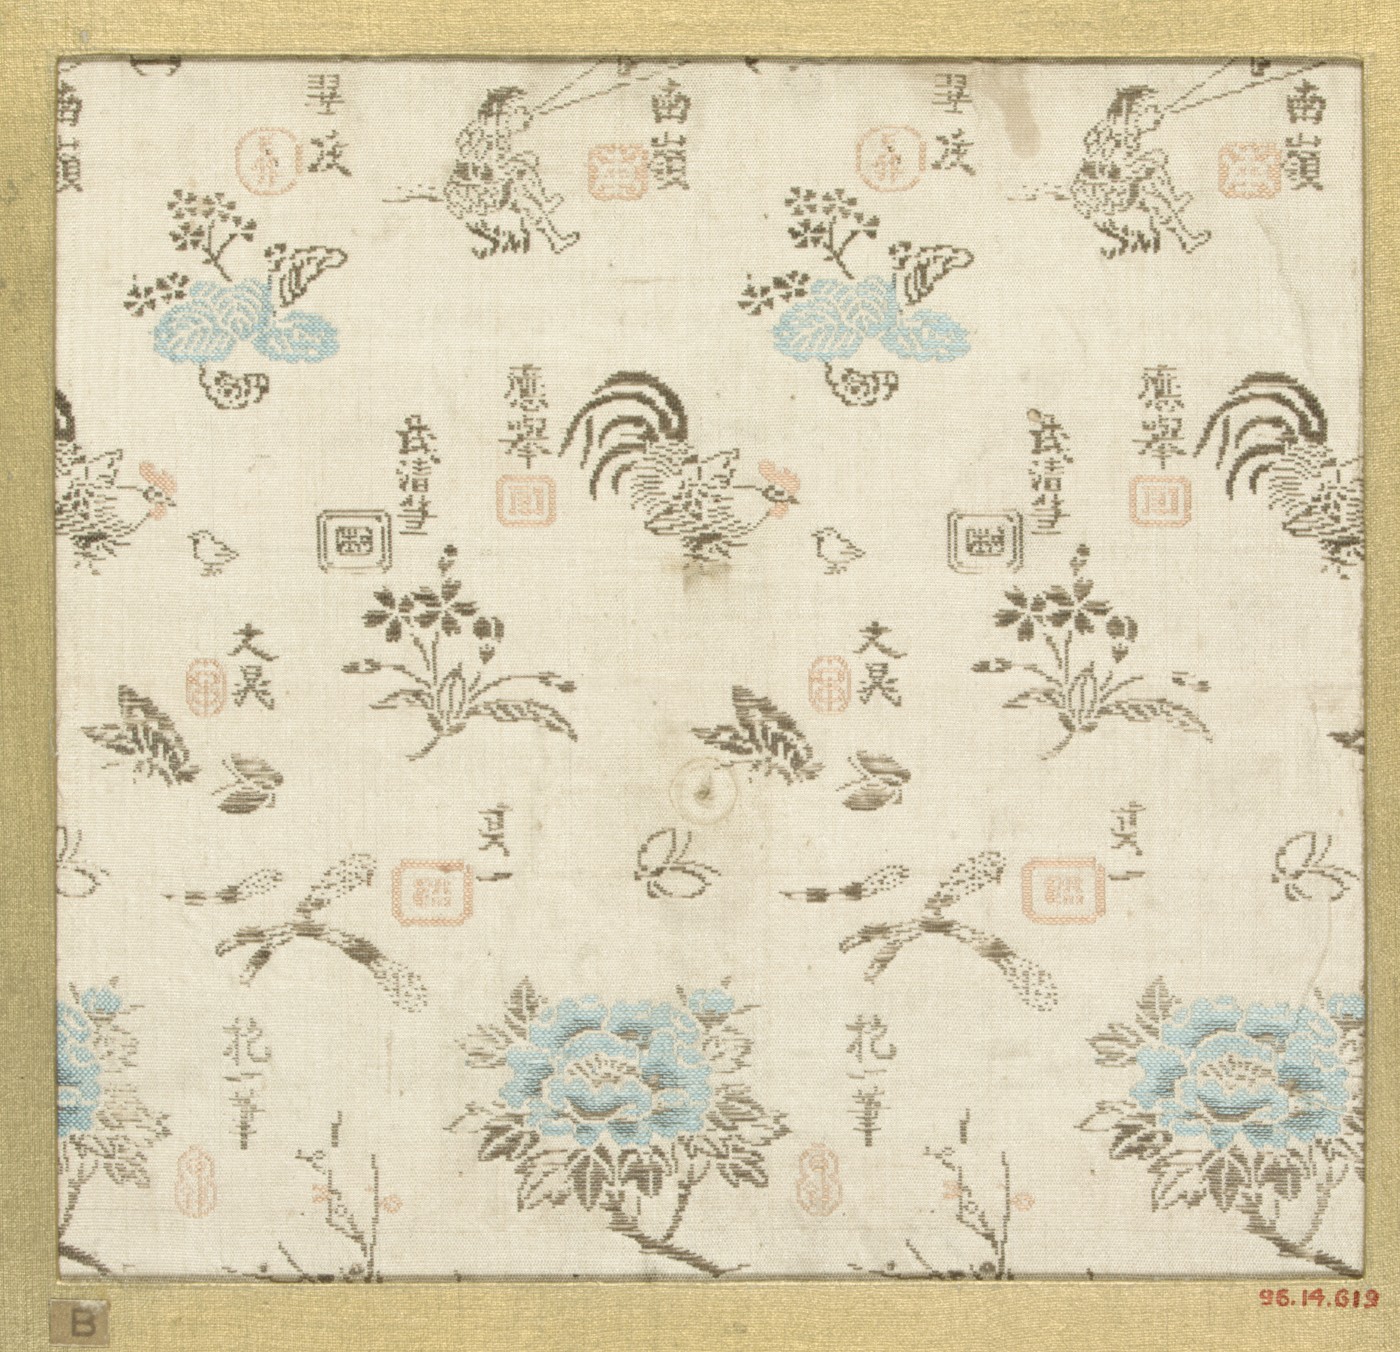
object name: piece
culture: japanese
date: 1701-1900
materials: silk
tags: human figures,butterflies,flowers